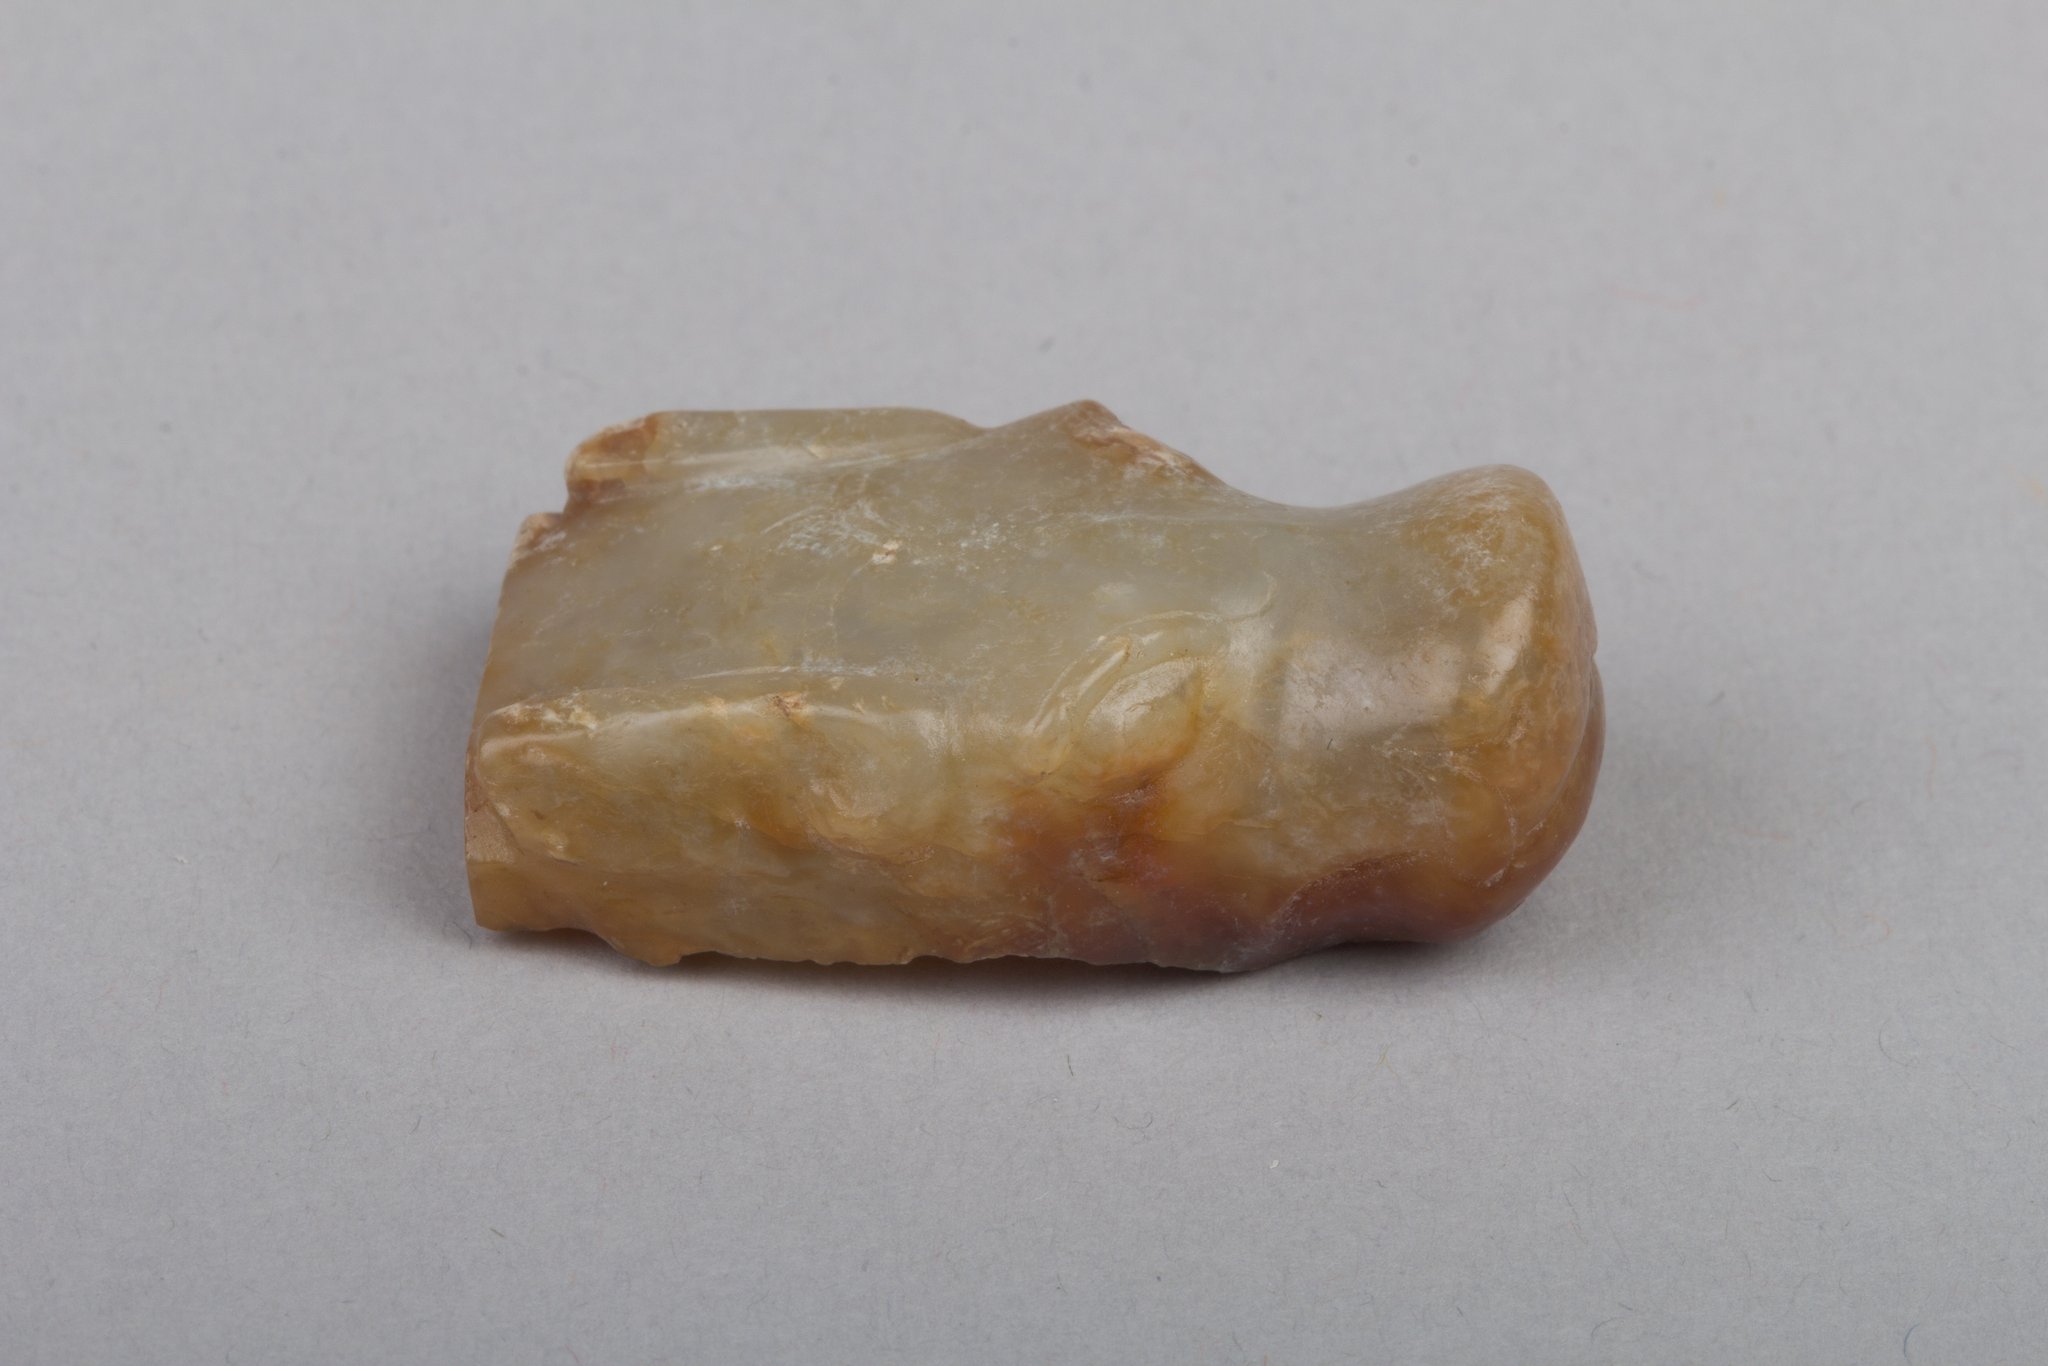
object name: head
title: Head of a Fantastic Animal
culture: chinese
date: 500-201 BCE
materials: jade